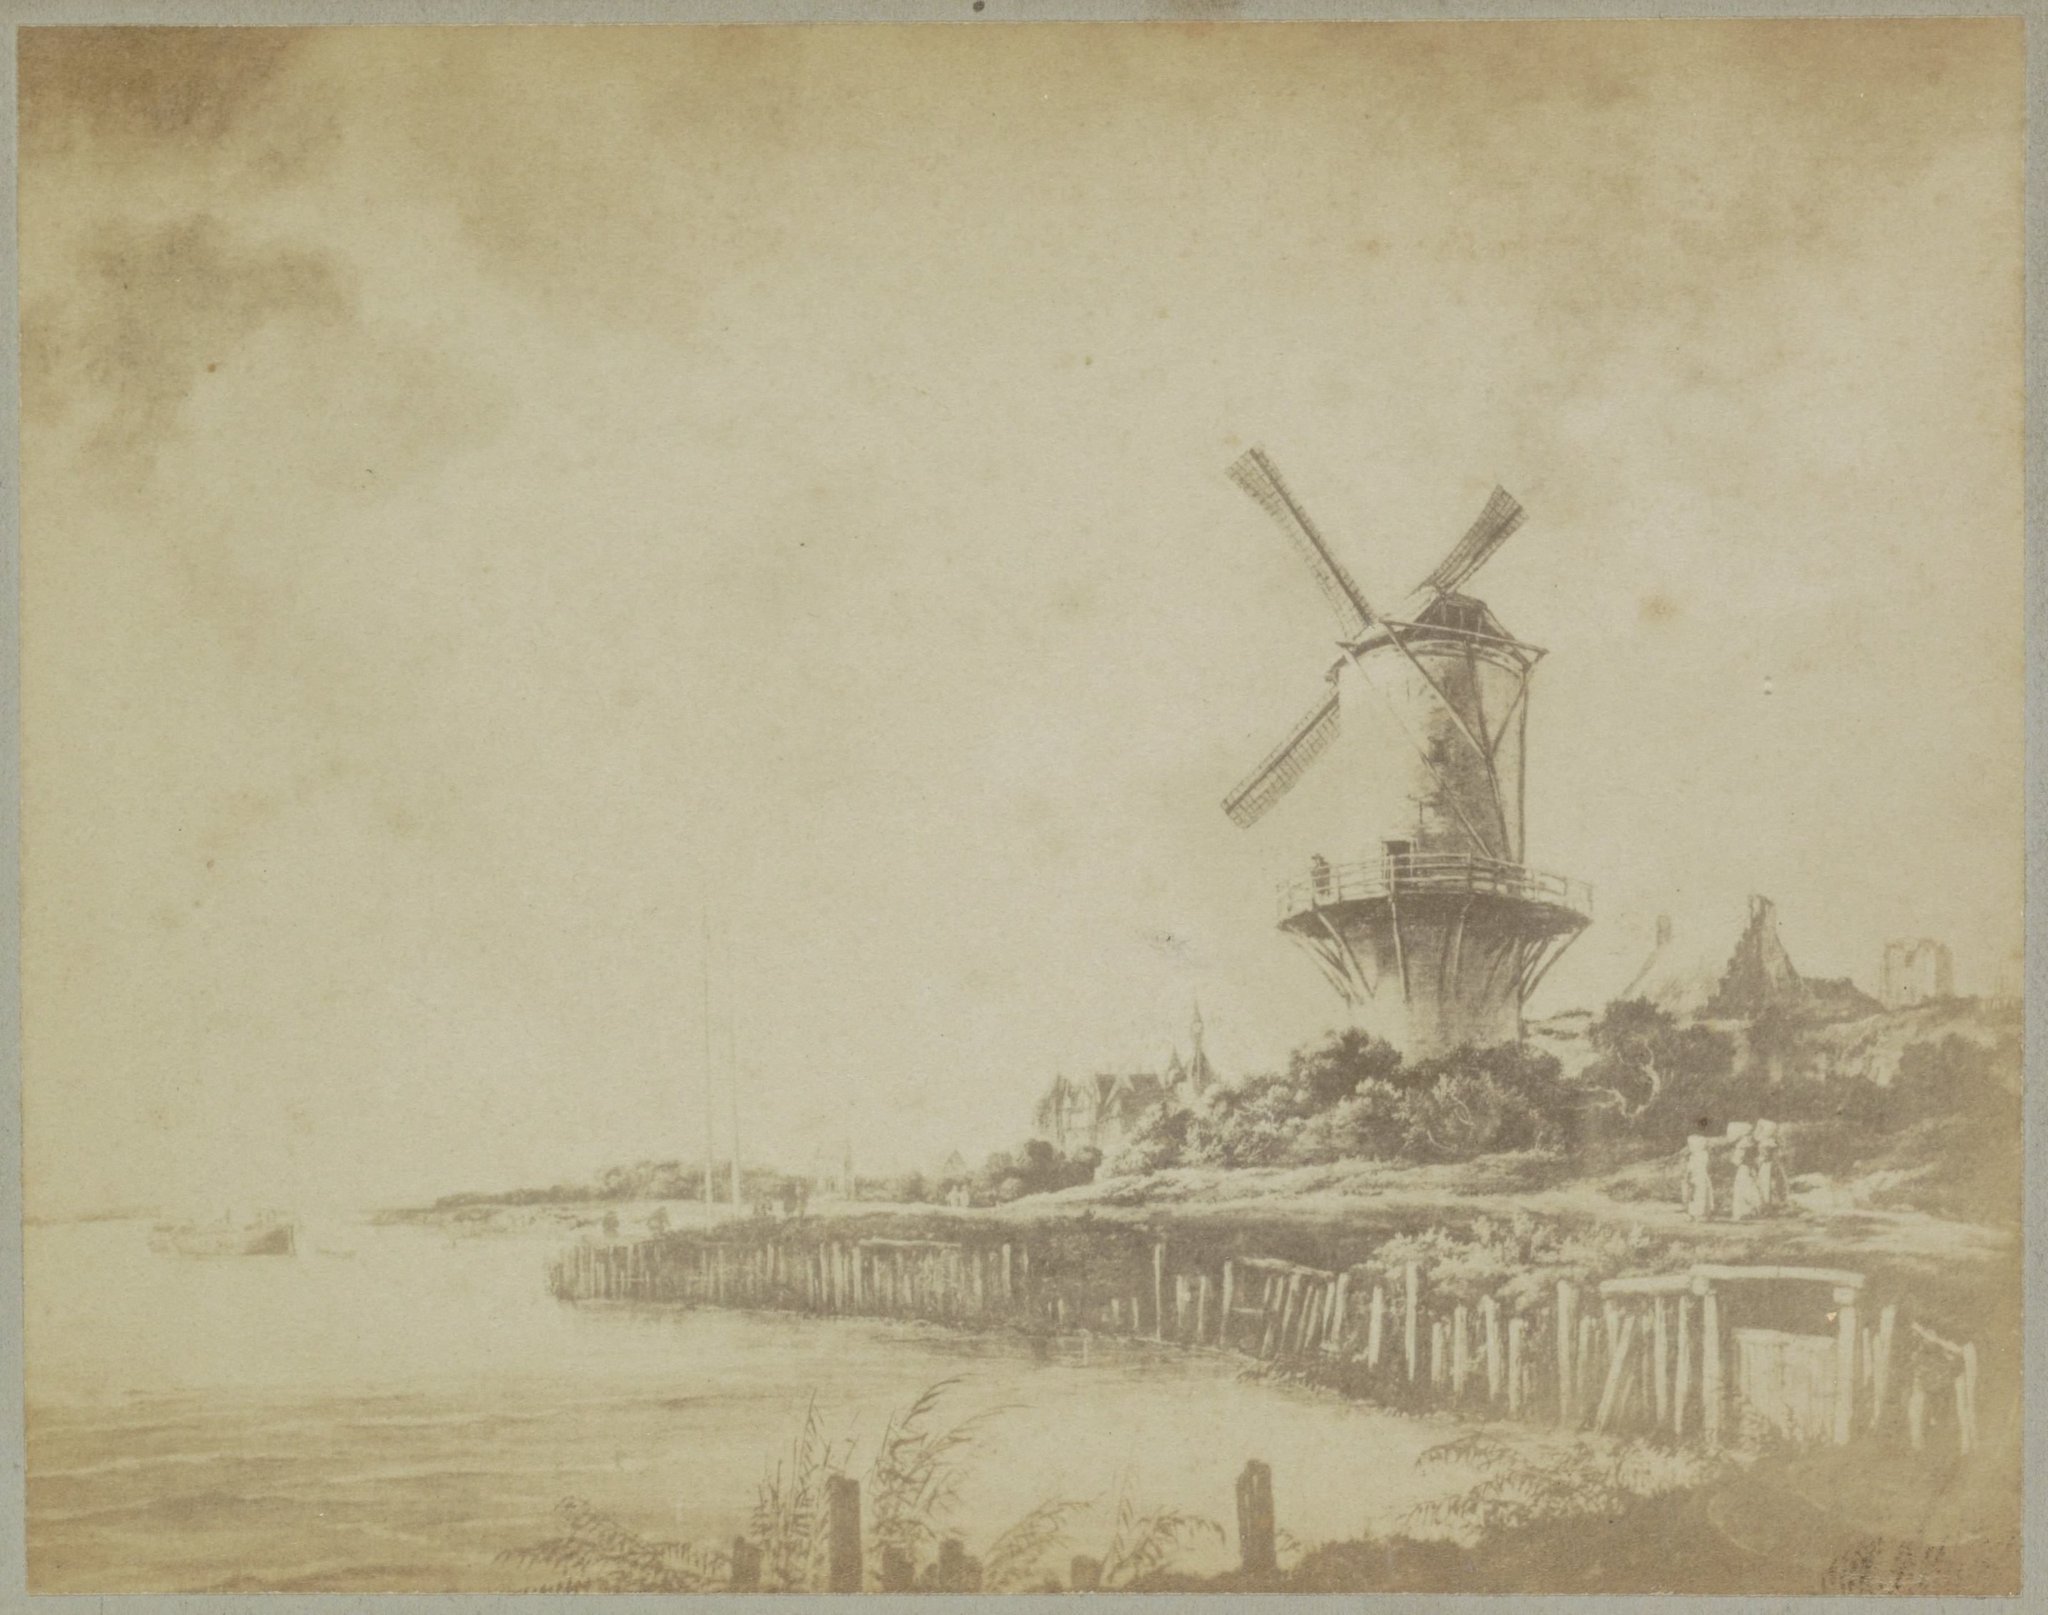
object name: reproduction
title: Musée d'Amsterdam. Jacob van Ruisdaël. - Vue du Rhin.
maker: johan marinus schalekamp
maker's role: publisher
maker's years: 1844-1912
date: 1893-1912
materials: cardboard, photographic support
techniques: albumen print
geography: amsterdam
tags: windmill in landscape, picture, painting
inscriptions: number: ‘18’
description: Onderdeel van Leporelloalbum met fotoreproducties van schilderijen uit het Rijksmuseum.